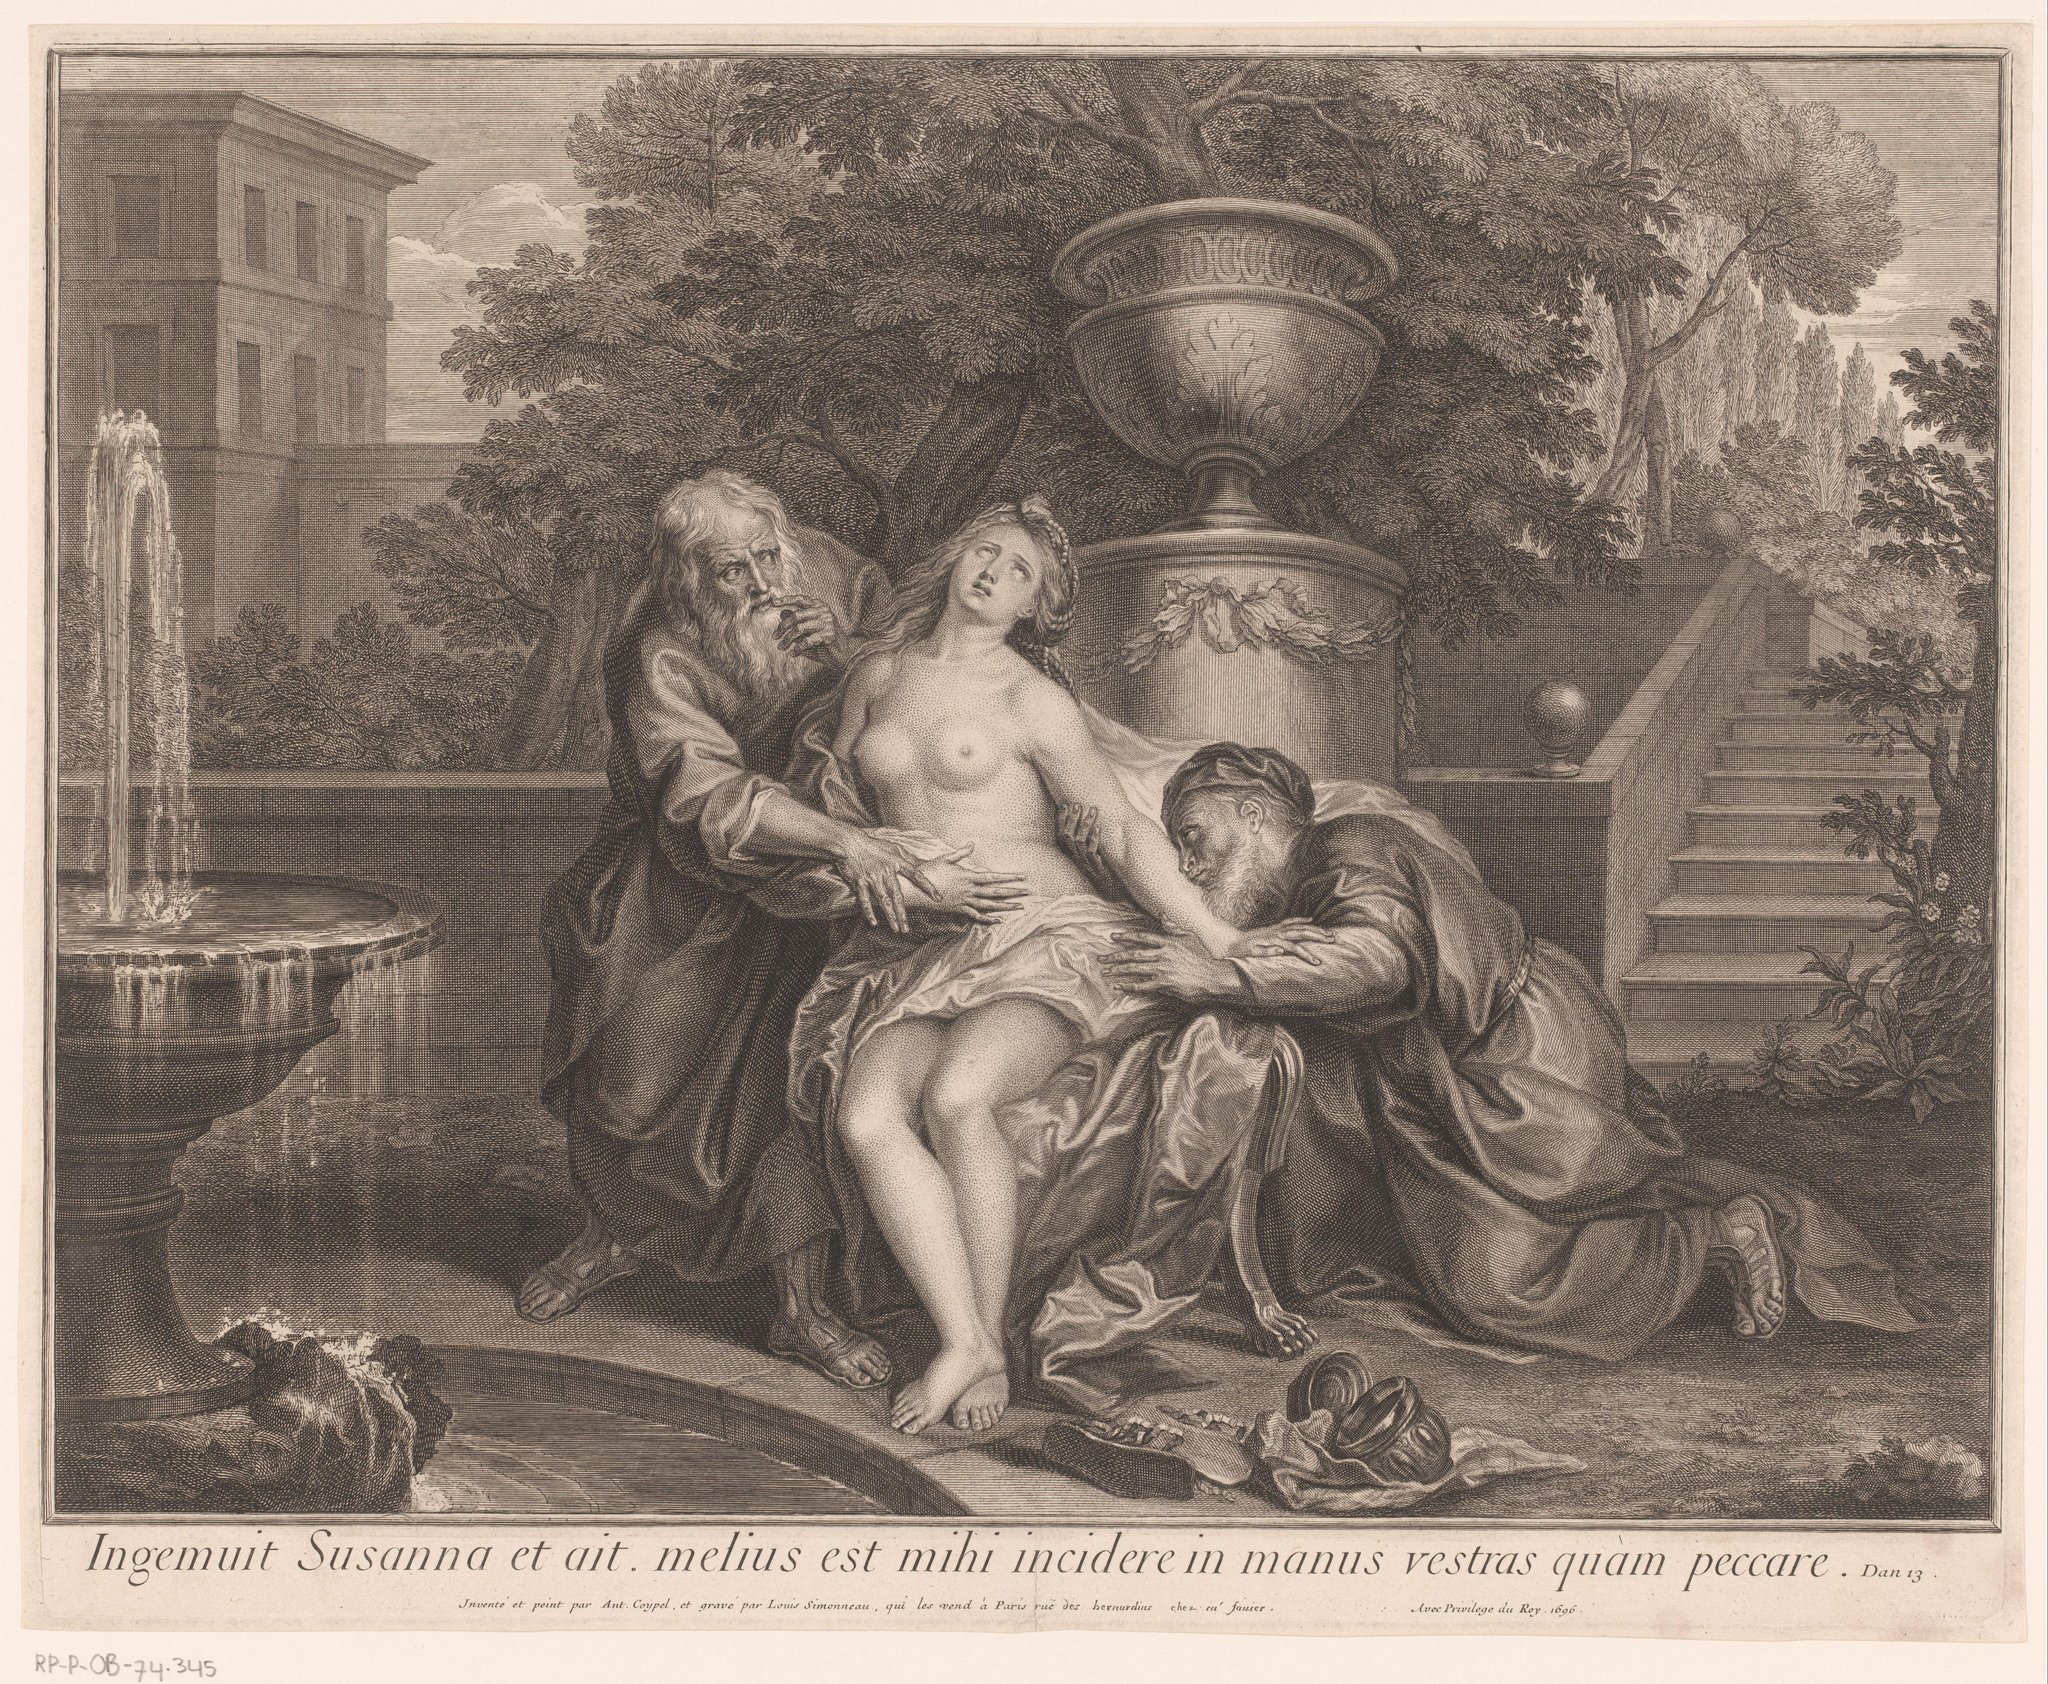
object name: print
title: Susanna en de ouderlingen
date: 1696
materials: paper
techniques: engraving, etching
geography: france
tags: the elders making advances towards susanna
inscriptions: collector's mark: Lugt 240